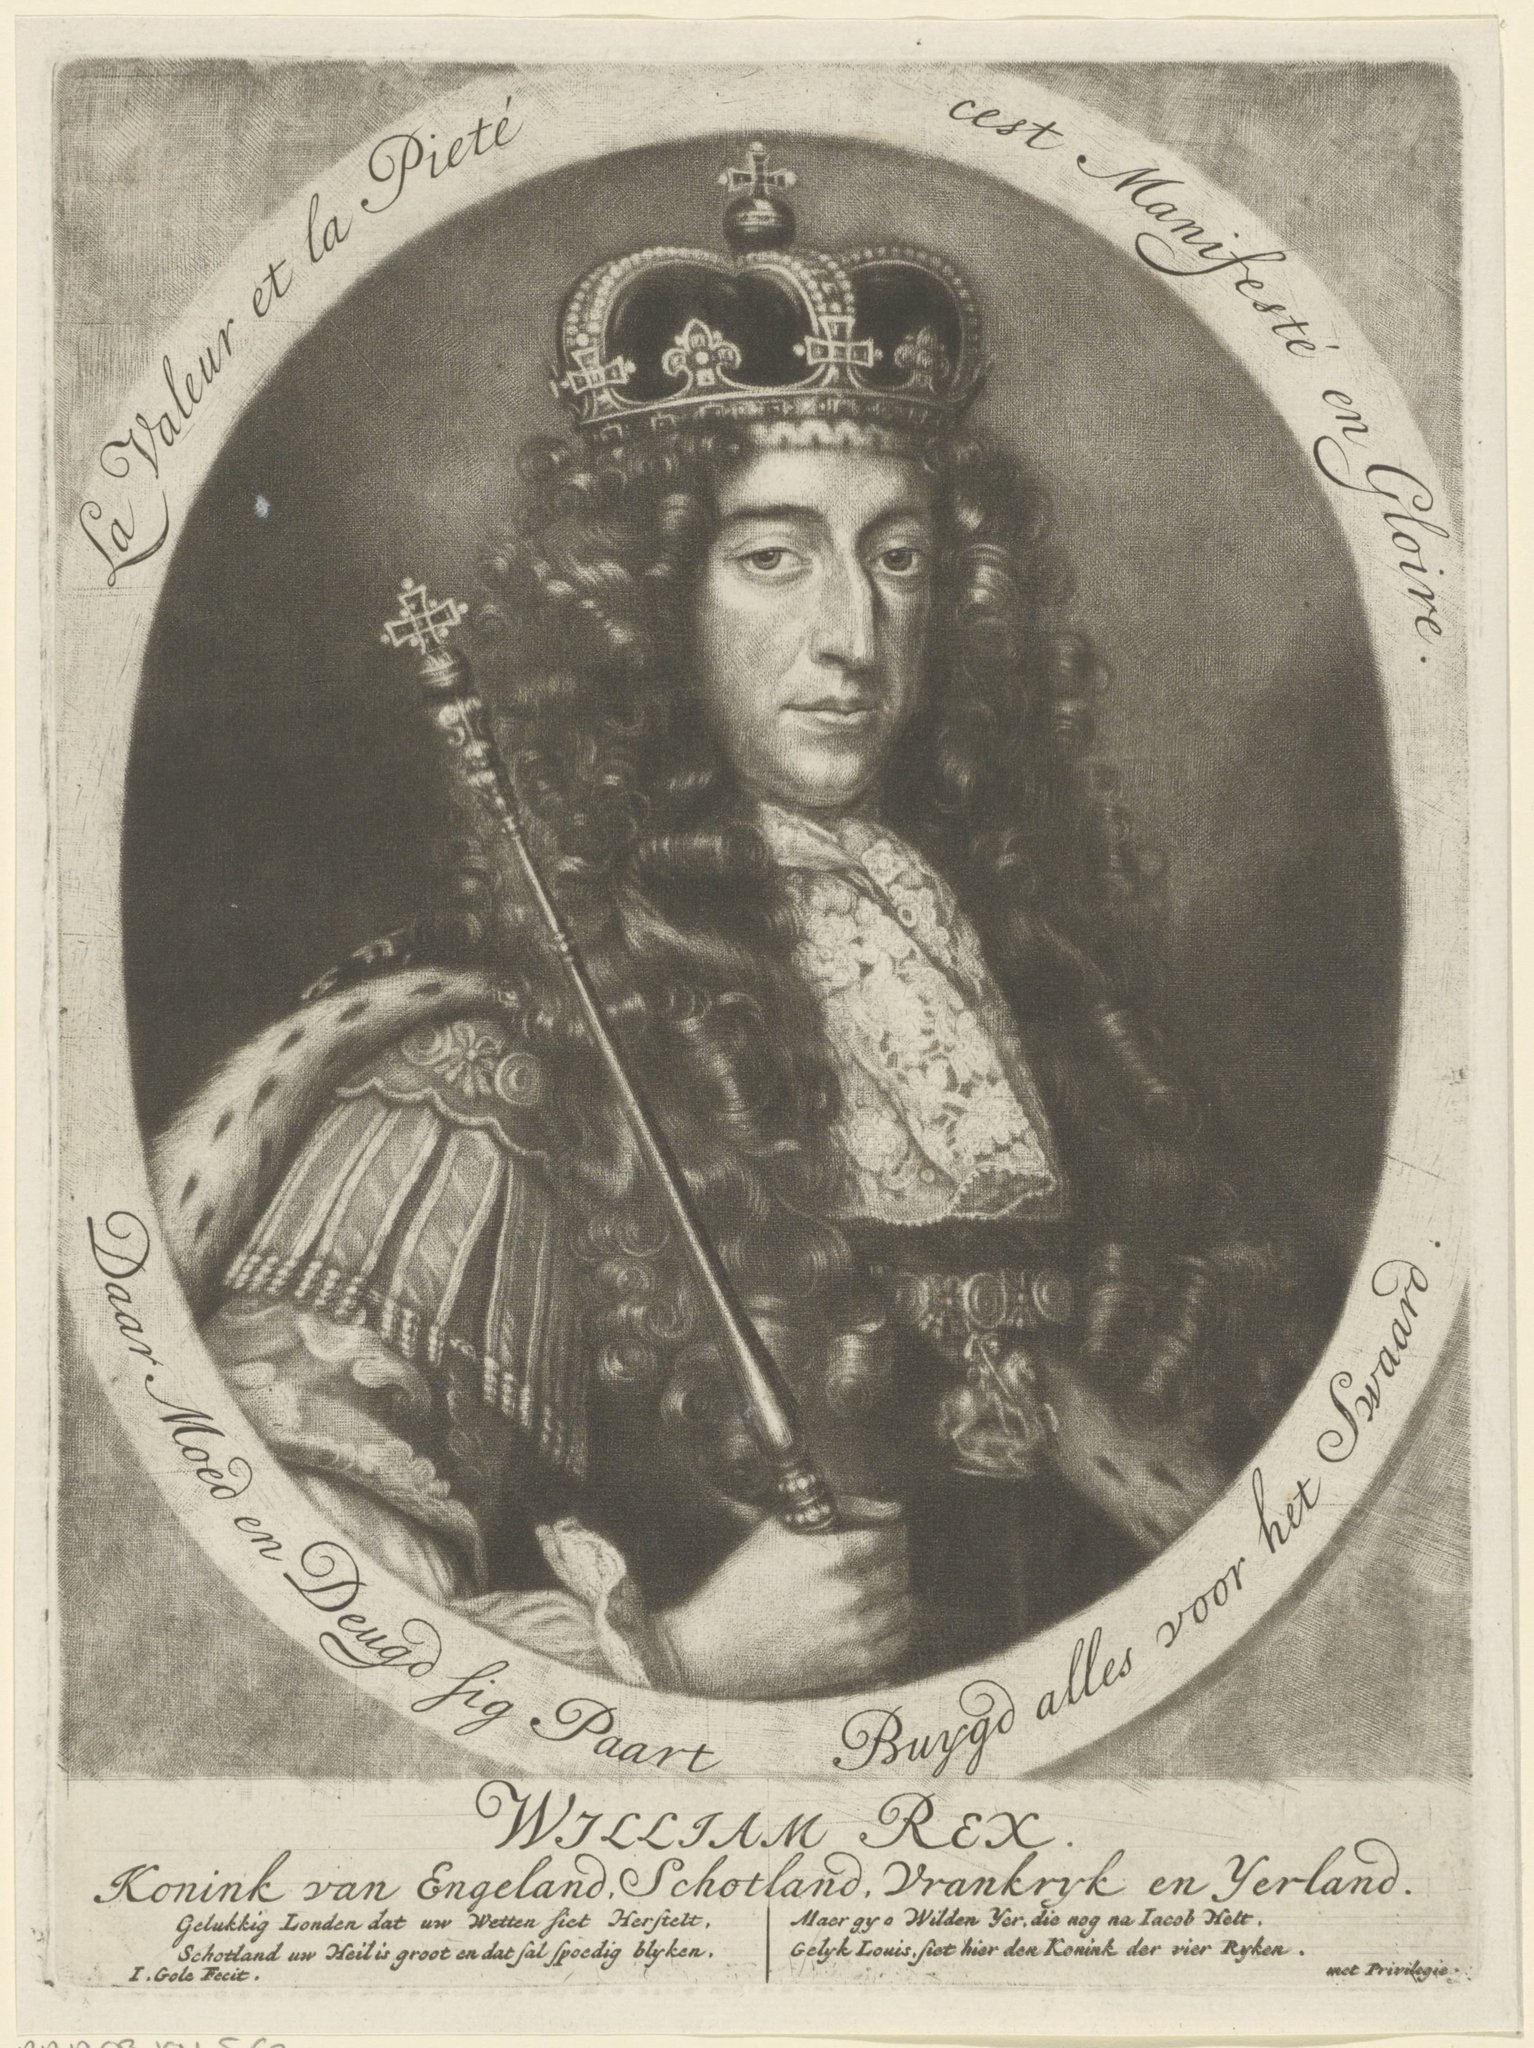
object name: print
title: Portret van Willem III, prins van Oranje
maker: jacob gole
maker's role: print maker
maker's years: 1660-1724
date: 1688-1724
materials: paper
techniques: mezzotint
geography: amsterdam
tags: william iii (prince of orange and king of england, scotland, and ireland), knighthood order (garter) - insignia of a knighthood order, e.g.: badge, chain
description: Portret van Willem III met een kroon in een ovaal met randschrift. In zijn rechterhand een scepter. In de ondermarge zijn naam, zijn titel en twee kolommen met elk twee regels Nederlandse tekst.